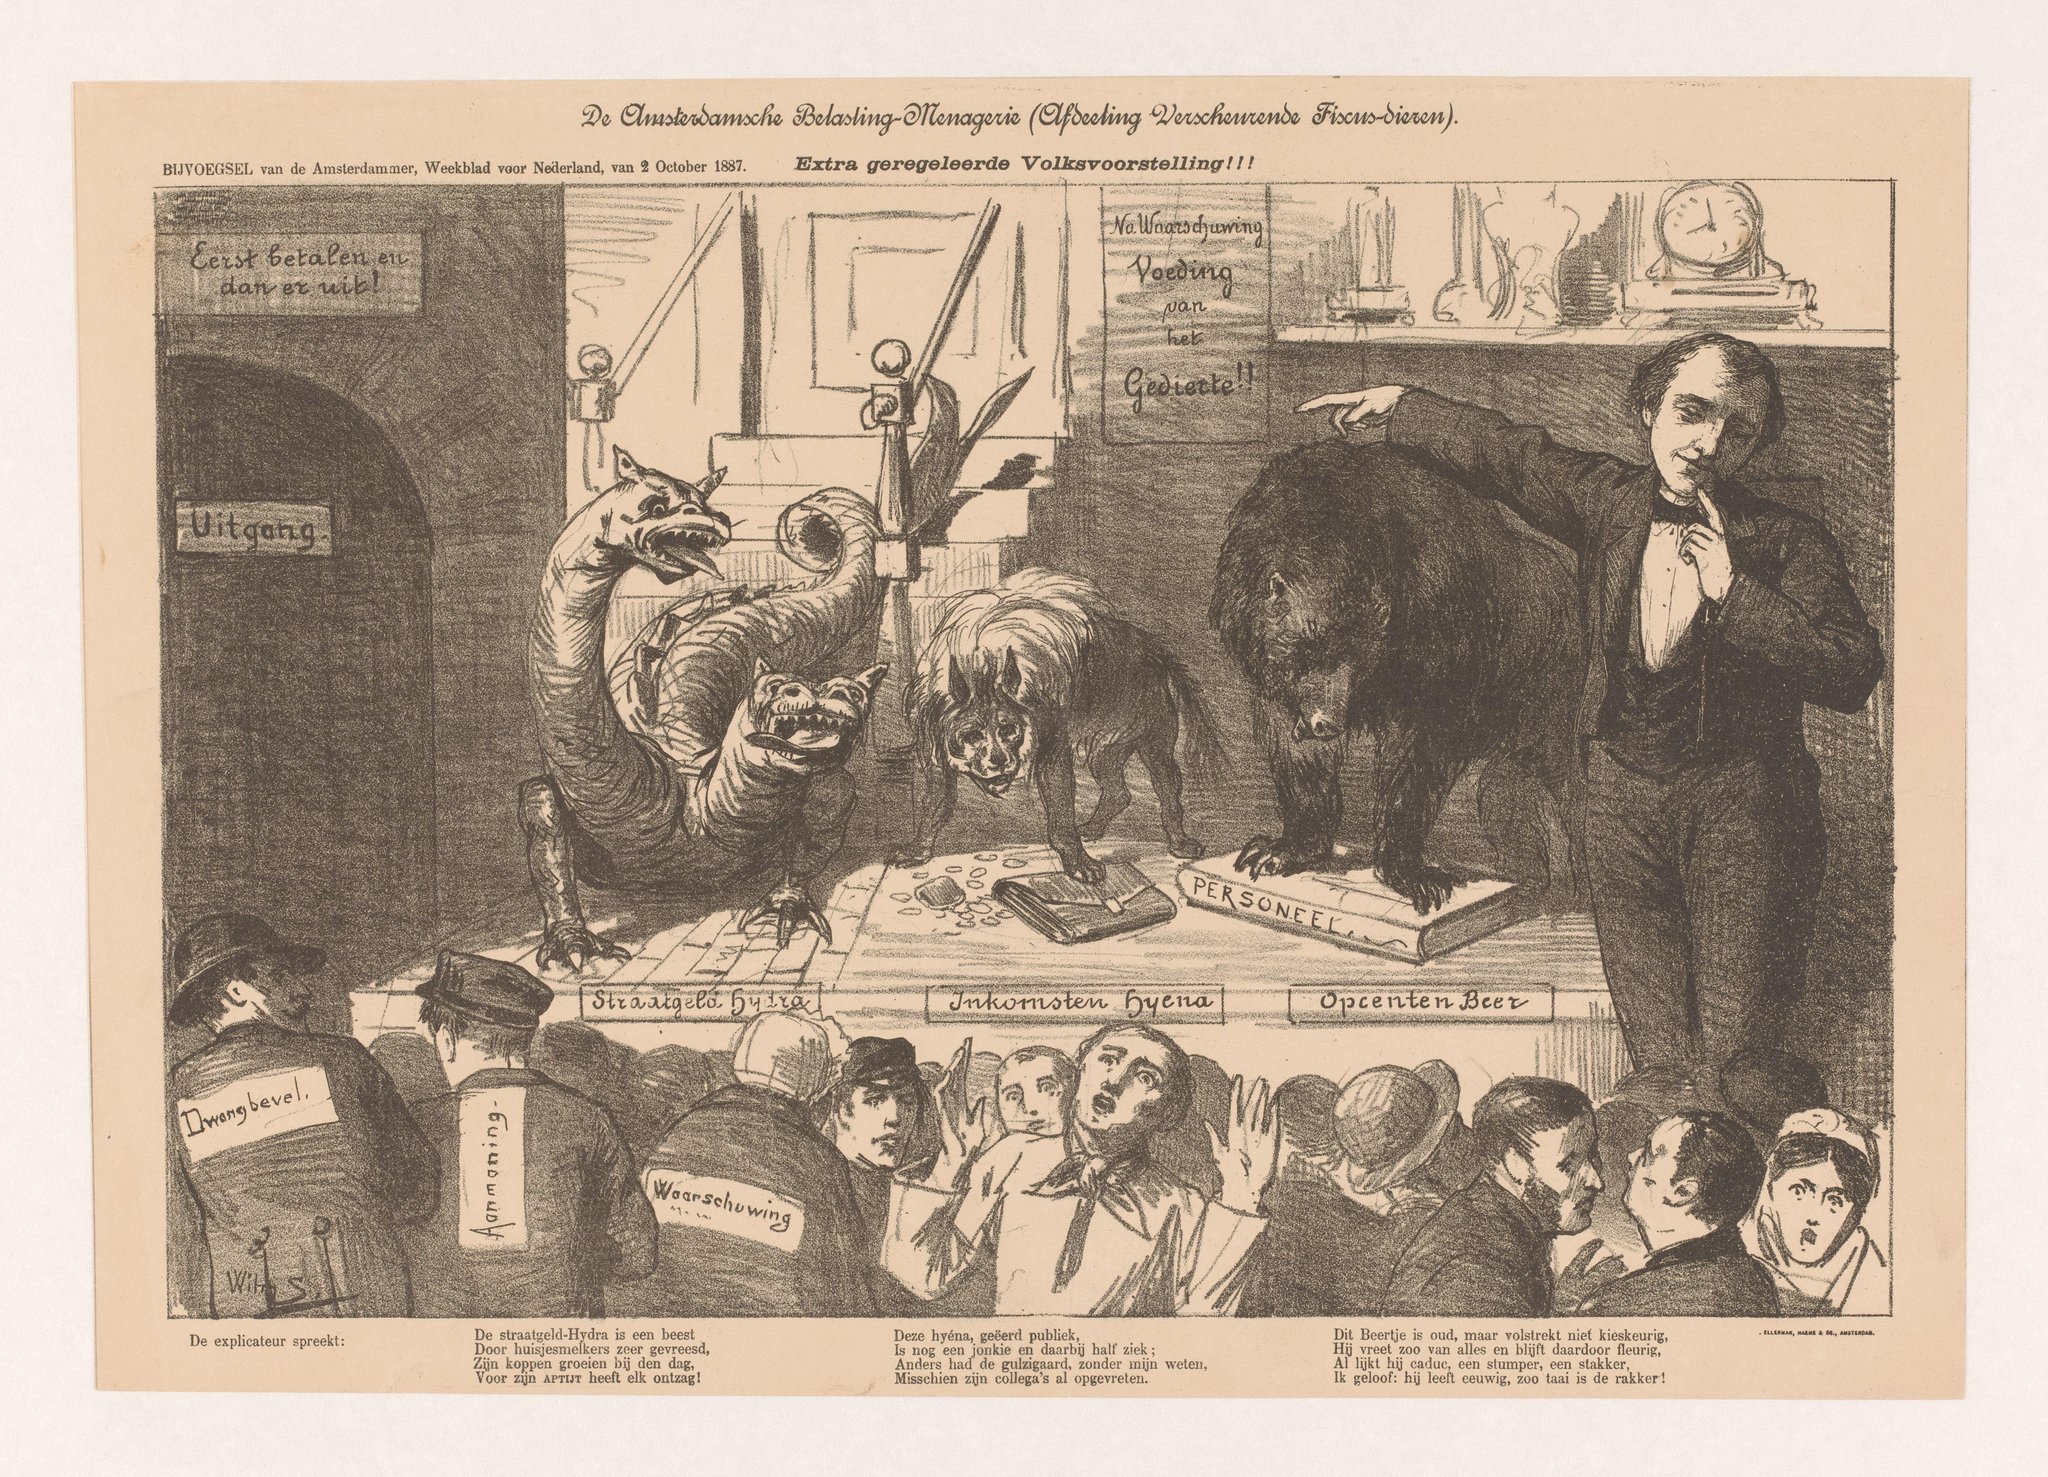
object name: cartoon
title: De Amsterdamsche Belasting-Menagerie (Afdeeling Verscheurende Fiscus-dieren)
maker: willem steelink (ii)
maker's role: draughtsman, print maker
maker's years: 1856-1928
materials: paper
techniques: lithograph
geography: amsterdam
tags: beasts of prey, predatory animals, taxes and financial administration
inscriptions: collector's mark: Lugt 2760, collector's mark: Lugt 2228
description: Een man toont zijn publiek drie monsterlijke dieren: de Straatgeld Hydra, de Inkomsten Hyena en de Opcenten beer. Tussen het publiek staan links Dwangbevel, Aanmaning en Waarschuwing.